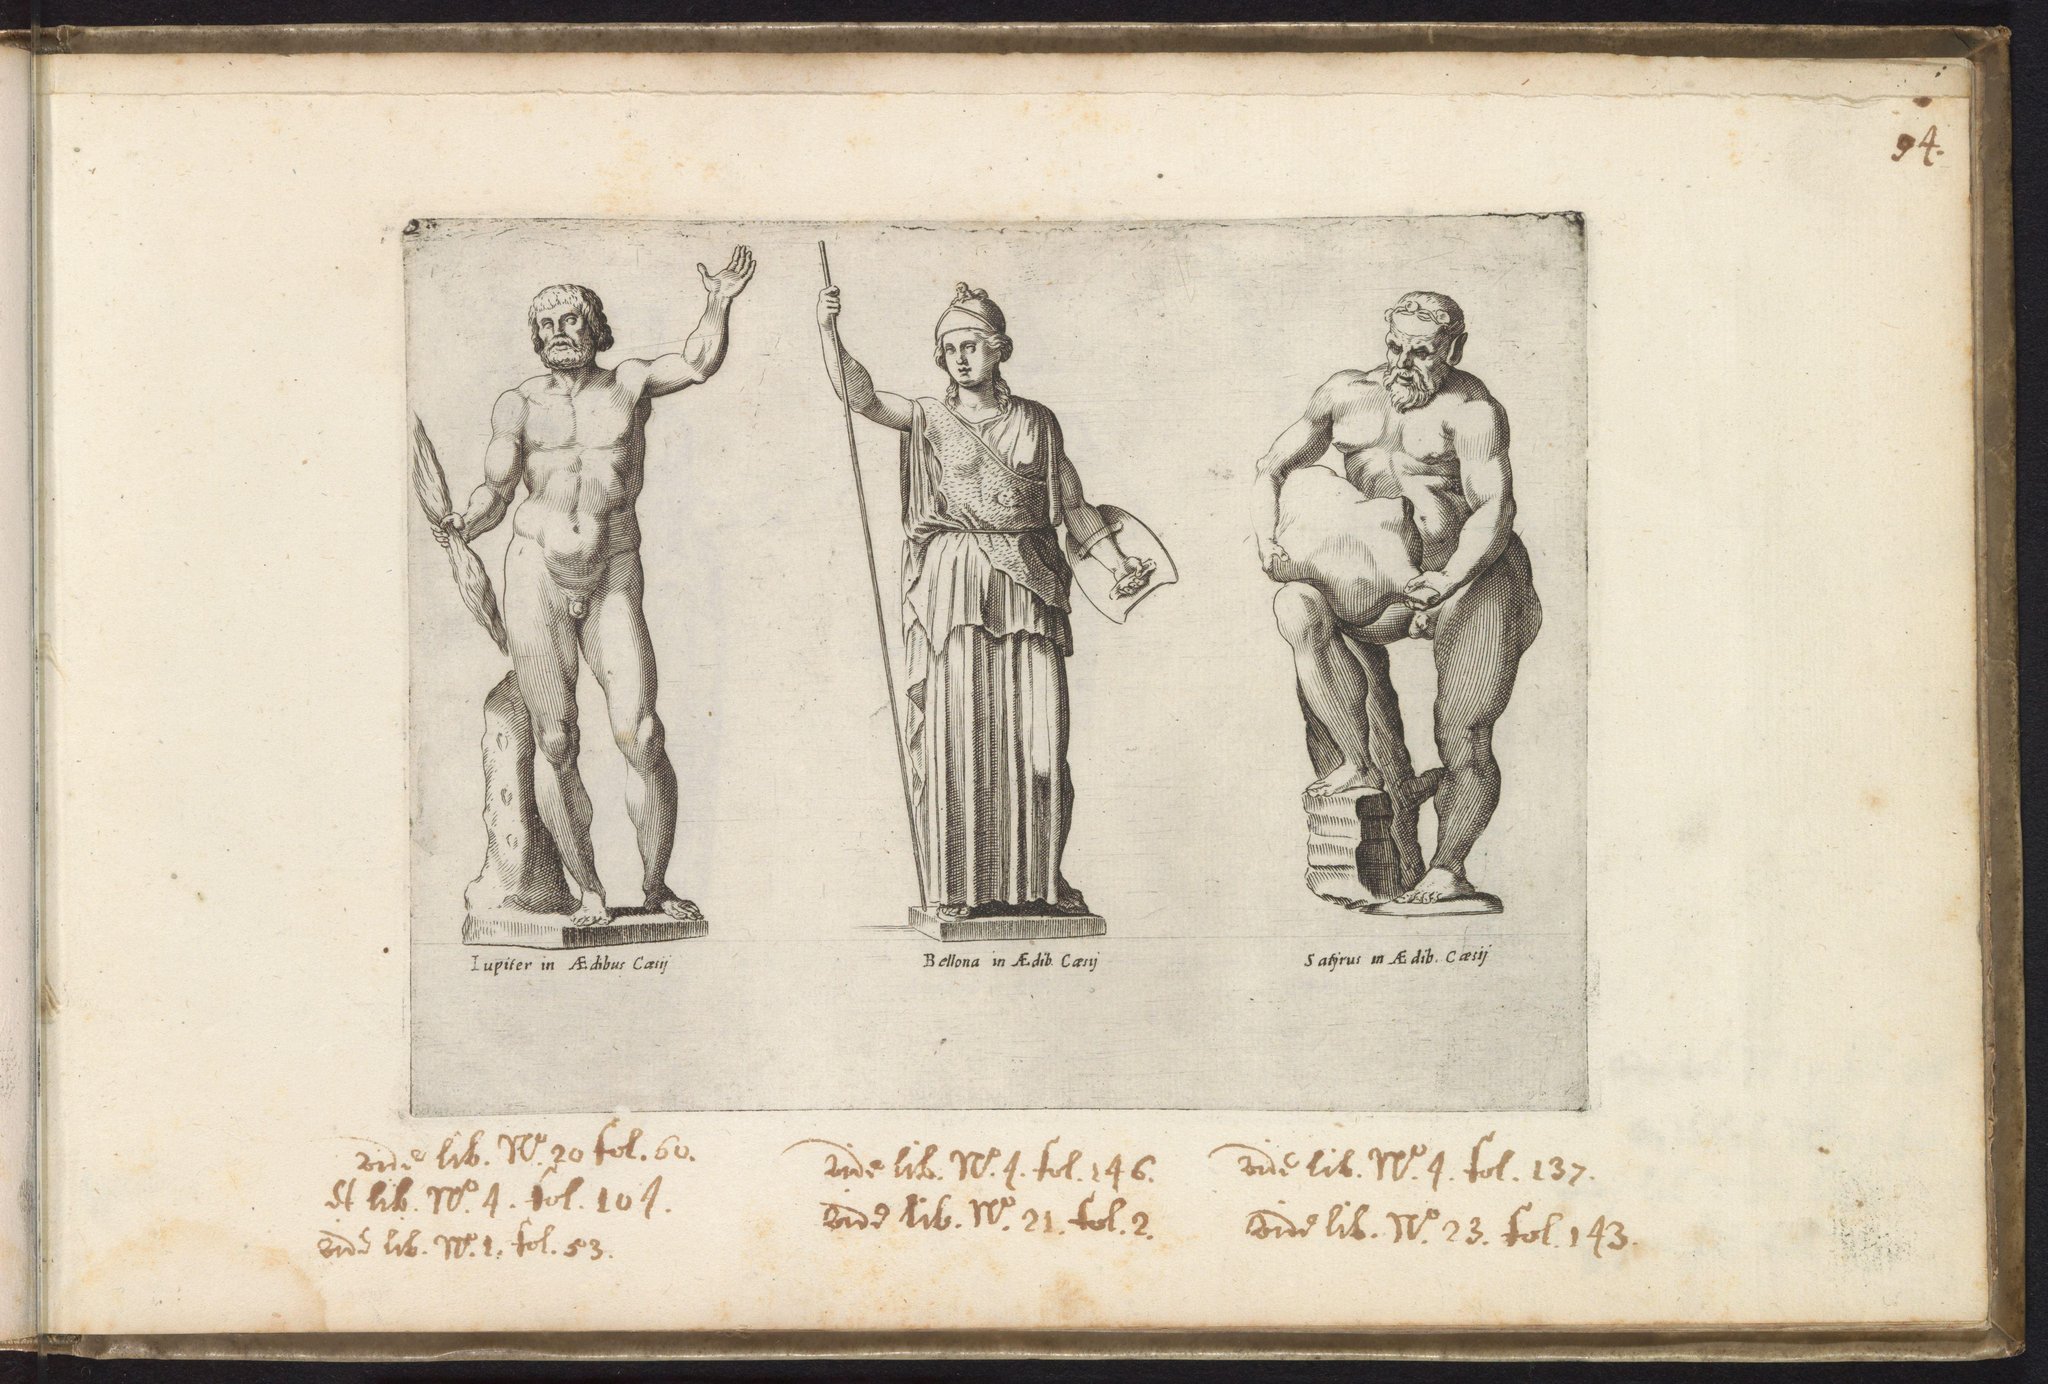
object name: album leaf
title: Sculpturen van Jupiter, Bellona en Silenus met een wijnzak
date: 1538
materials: paper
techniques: engraving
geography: italy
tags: (story of) jupiter (zeus), (story of) silenus, piece of sculpture, reproduction of a piece of sculpture, bellona (enyo)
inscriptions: number: ‘94’, inscription: ‘Ende lib. No. 20 fol. 60./ et lib. No. 4. fol. 104./ Ende lib. No. 1. fol. 53 [...] Ende lib. No. 23. fol. 143.’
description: Deze prent maakt deel uit van een reeks van ten minste 19 prenten van sculpturen uit de oudheid.